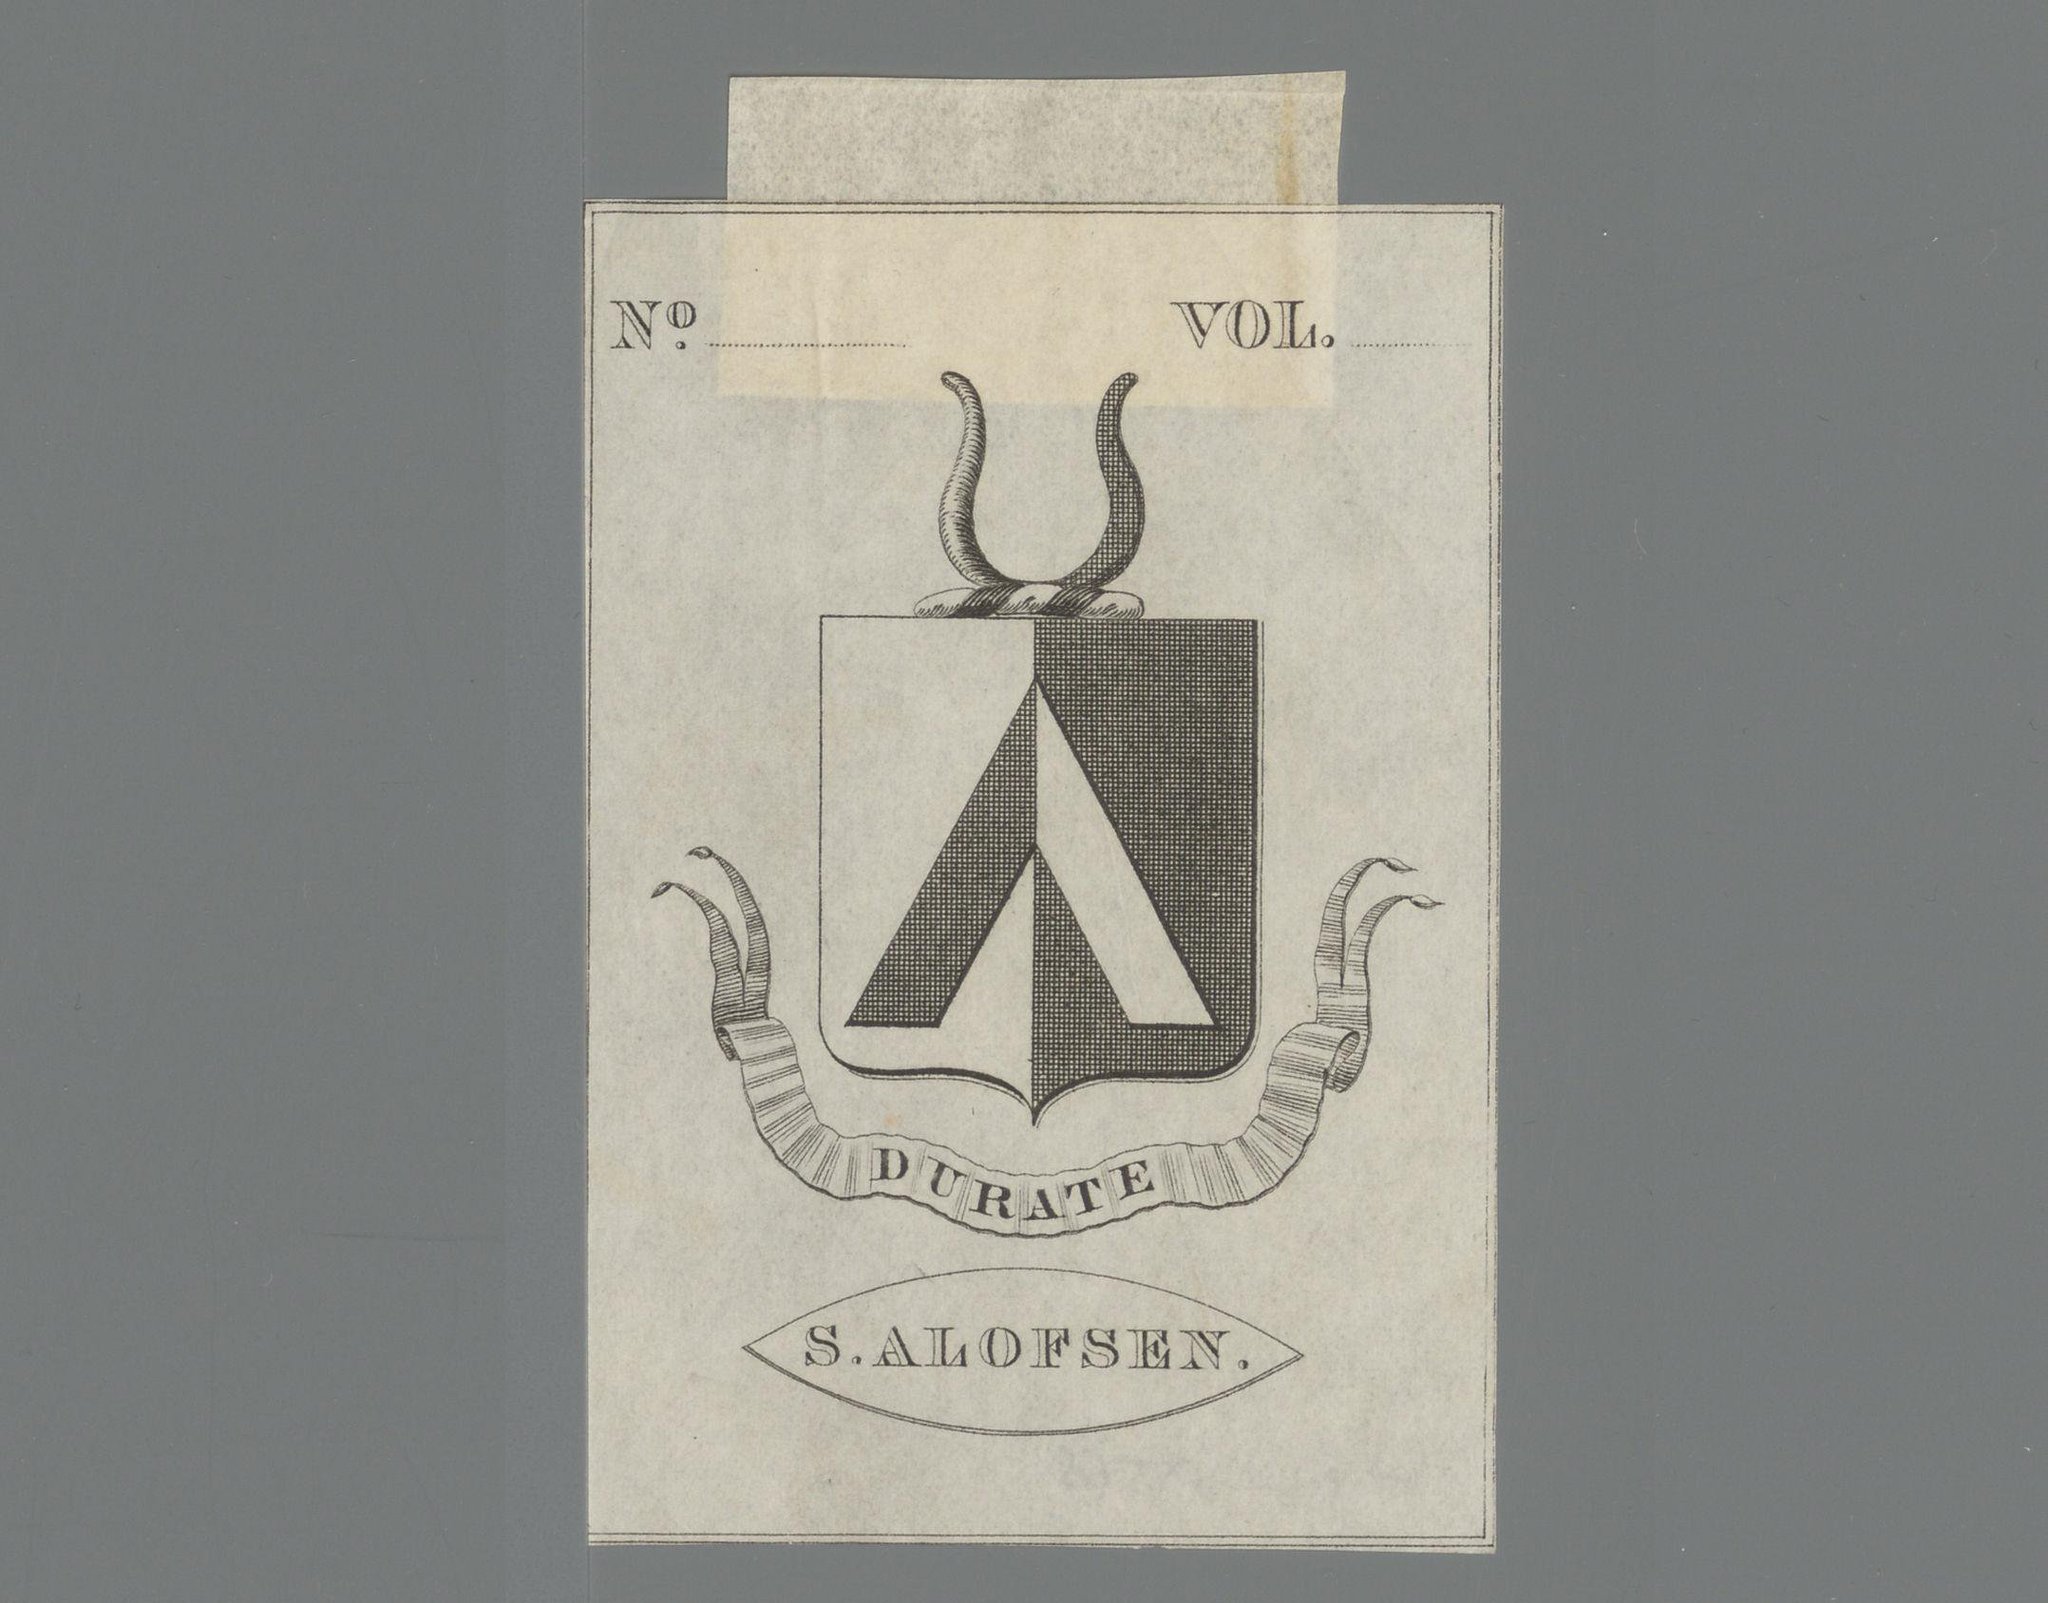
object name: bookplate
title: Ex libris van S. Alofsen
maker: Anonymous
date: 1818-1876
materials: paper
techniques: etching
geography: netherlands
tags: armorial bearing, heraldry